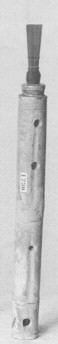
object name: tibia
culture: italian, roman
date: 100 BCE-200 CE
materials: bone, cement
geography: italy